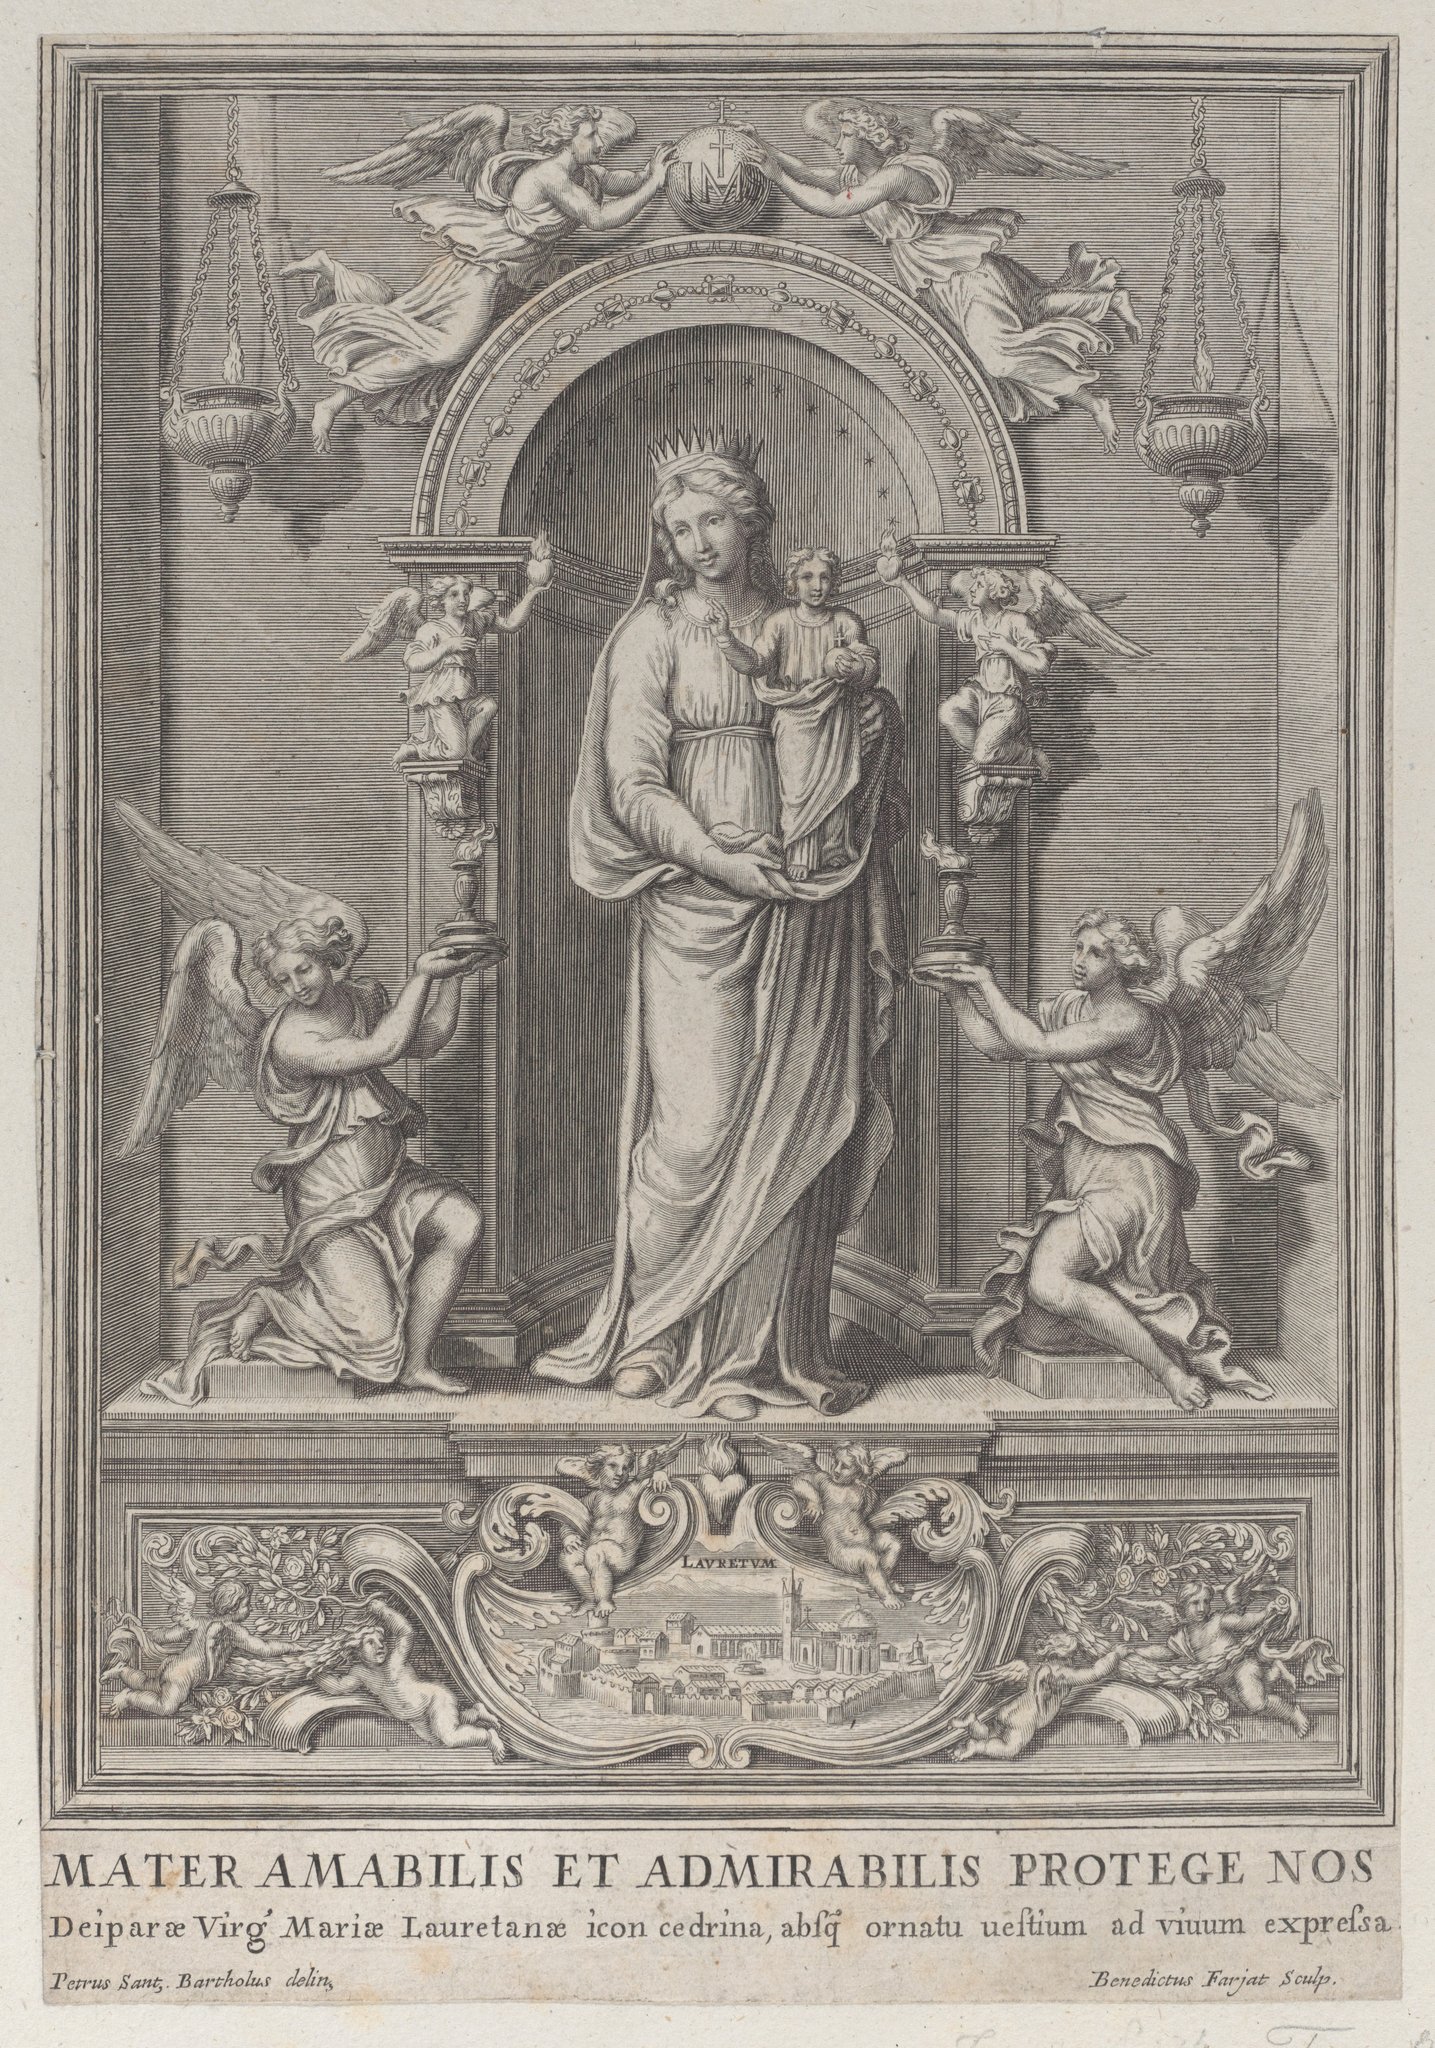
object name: print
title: Madonna of Loreto, within a niche with an angel on either side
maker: benoit farjat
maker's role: artist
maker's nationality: french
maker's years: 1626-1724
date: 1650-1724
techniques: etching